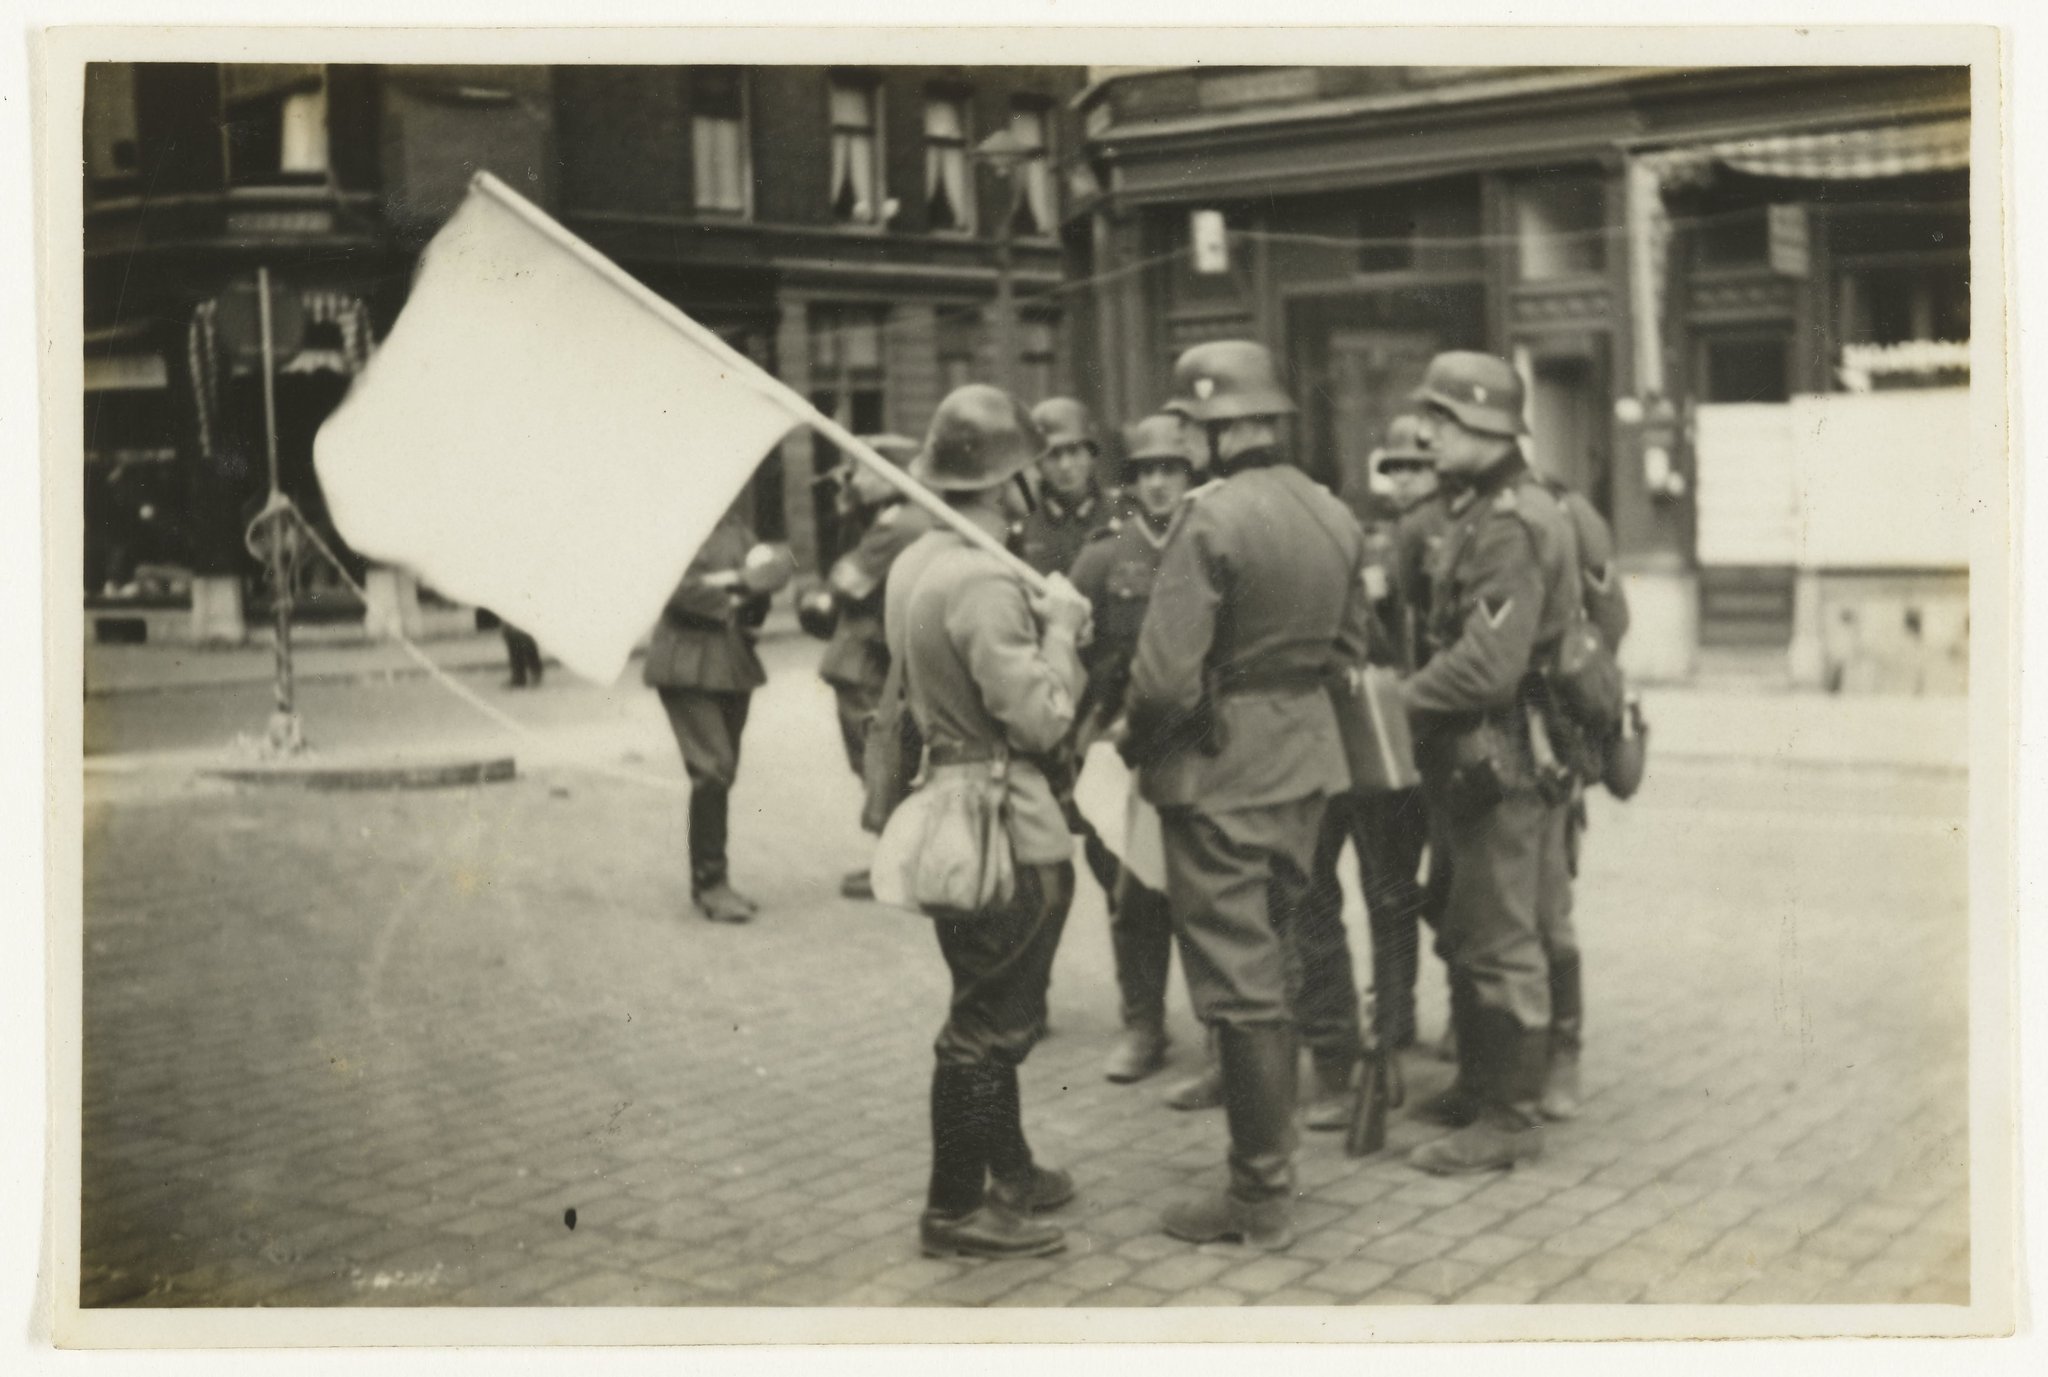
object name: photograph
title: Rotterdam tijdens de overgave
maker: Anonymous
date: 1940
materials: photographic support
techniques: gelatin silver print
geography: rotterdam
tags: the defeated (after the battle), march into the conquered place, rotterdam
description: Een vijftal Duitse militairen staan met de Nederlandse sergeant-majoor Van Ommering, met de witte vlag, in de Van der Takstraat in Rotterdam. Het is omstreeks 1600 uur in de middag van de 14de mei, kort na het Duitse bombardement. Kapitein Backer en Kolonel Scharroo zijn op dat moment bij de Duitse bevelhebber om de overgave van de stad aan te bieden.